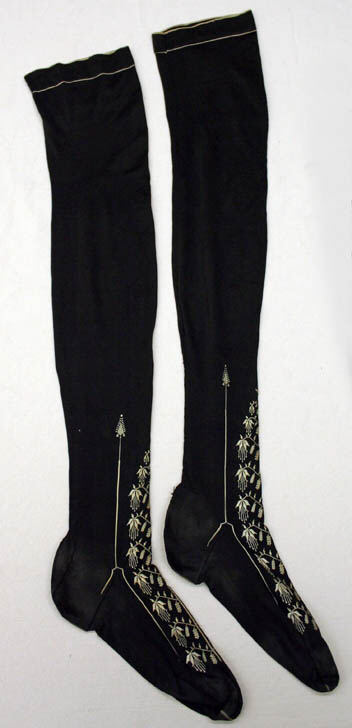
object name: stocking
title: Stockings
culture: european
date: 1830-1839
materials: silk